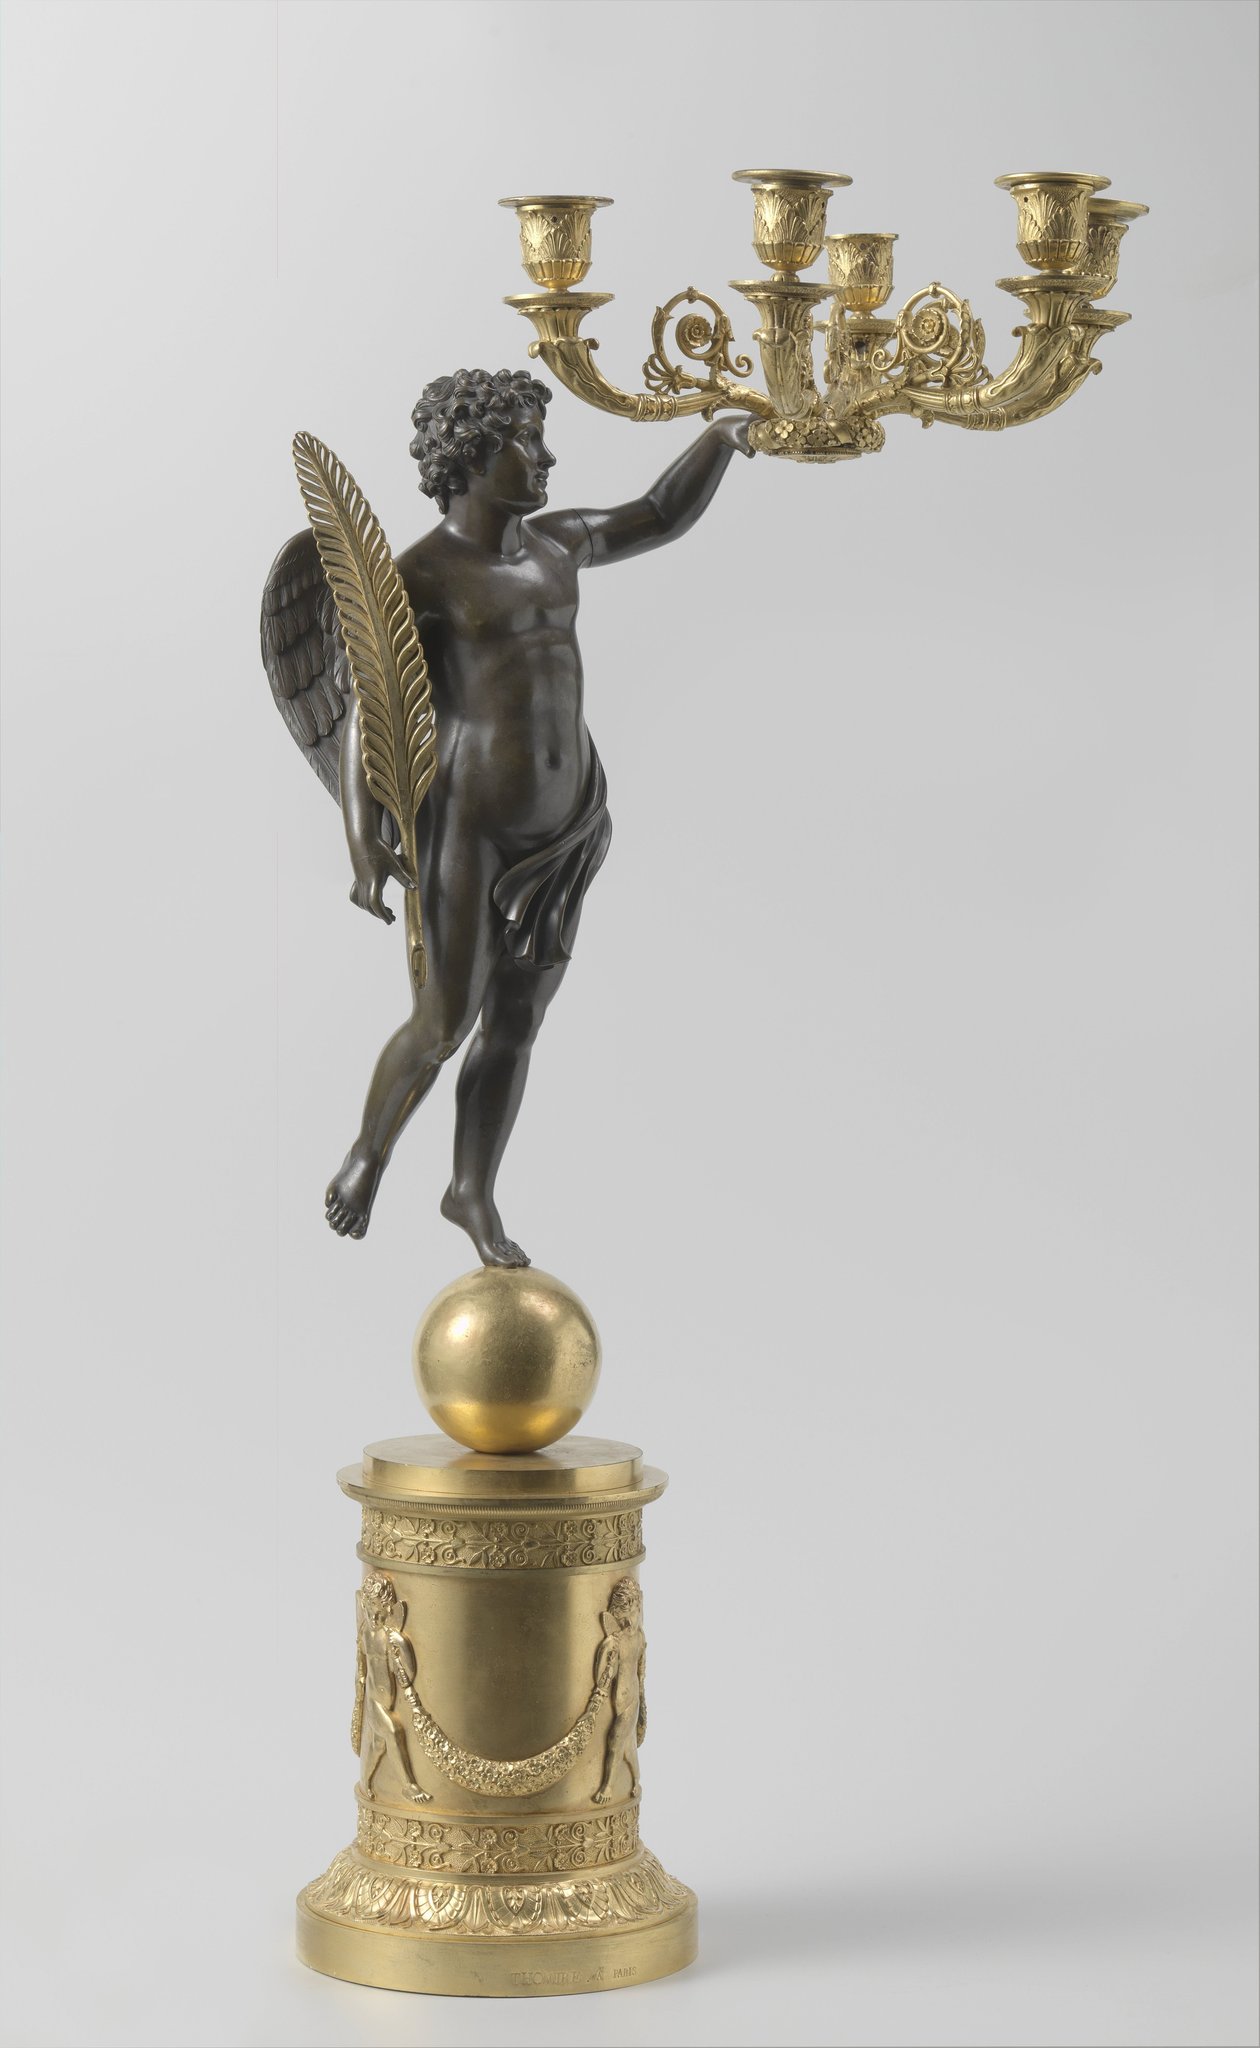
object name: candlestick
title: Kandelaar van gedeeltelijk verguld brons, versierd met o.a. palmetten, gestileerde bloemranken, dansende putti met guirlande en een figuur in zweefstand met veer in de hand.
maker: pierre philippe thomire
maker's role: brazier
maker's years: 1751-1843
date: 1815-1825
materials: bronze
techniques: gilding, patinaed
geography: paris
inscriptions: signature: ‘THOMIRE . A PARIS’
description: Bed. Mahogany and other woods, partly gilded, gilt bronze mounts. Netherlands, c. 1808. From Paviljoen Welgelegen in Haarlem. Probably supplied to King Louis Napoleon while in residence there. Two firedogs. Gilt bronze. Paris, c. 1800. Two candelabra. Gilt and patinated bronze. Paris, c. 1800, by Pierre Philippe Thomire. Presented by the staff of the Rijksmuseum on the 50th anniversary of the museum building, 1935.